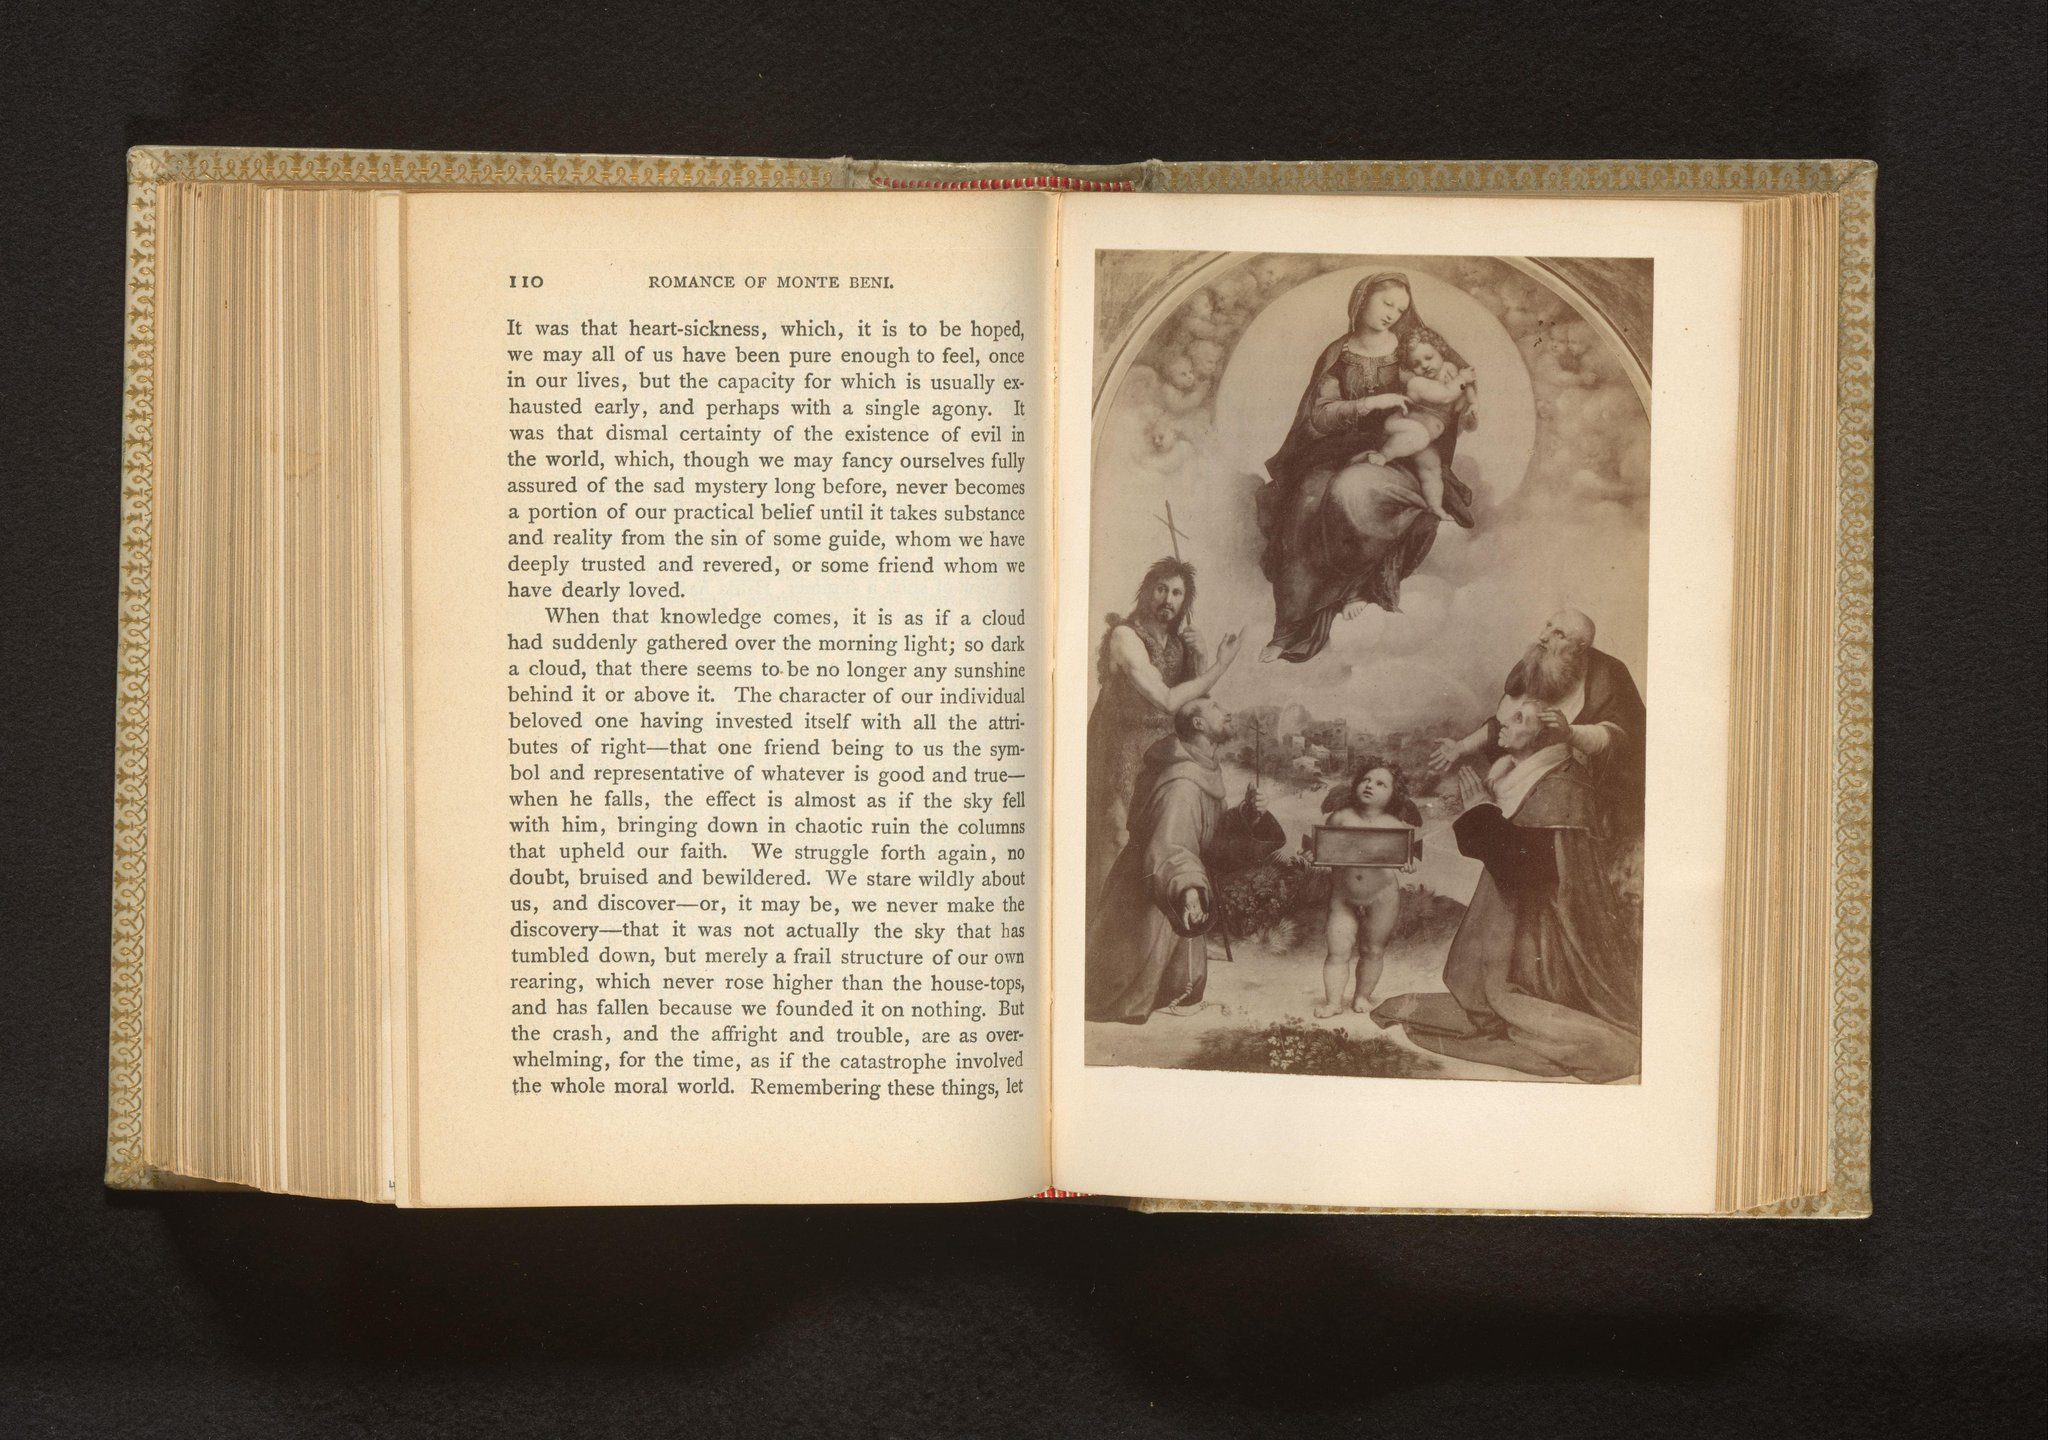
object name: reproduction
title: Fotoreproductie van een prent naar de Madonna di Foligno door Rafaël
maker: Anonymous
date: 1850-1860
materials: photographic support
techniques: albumen print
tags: madonna: i.e. mary with the christ-child